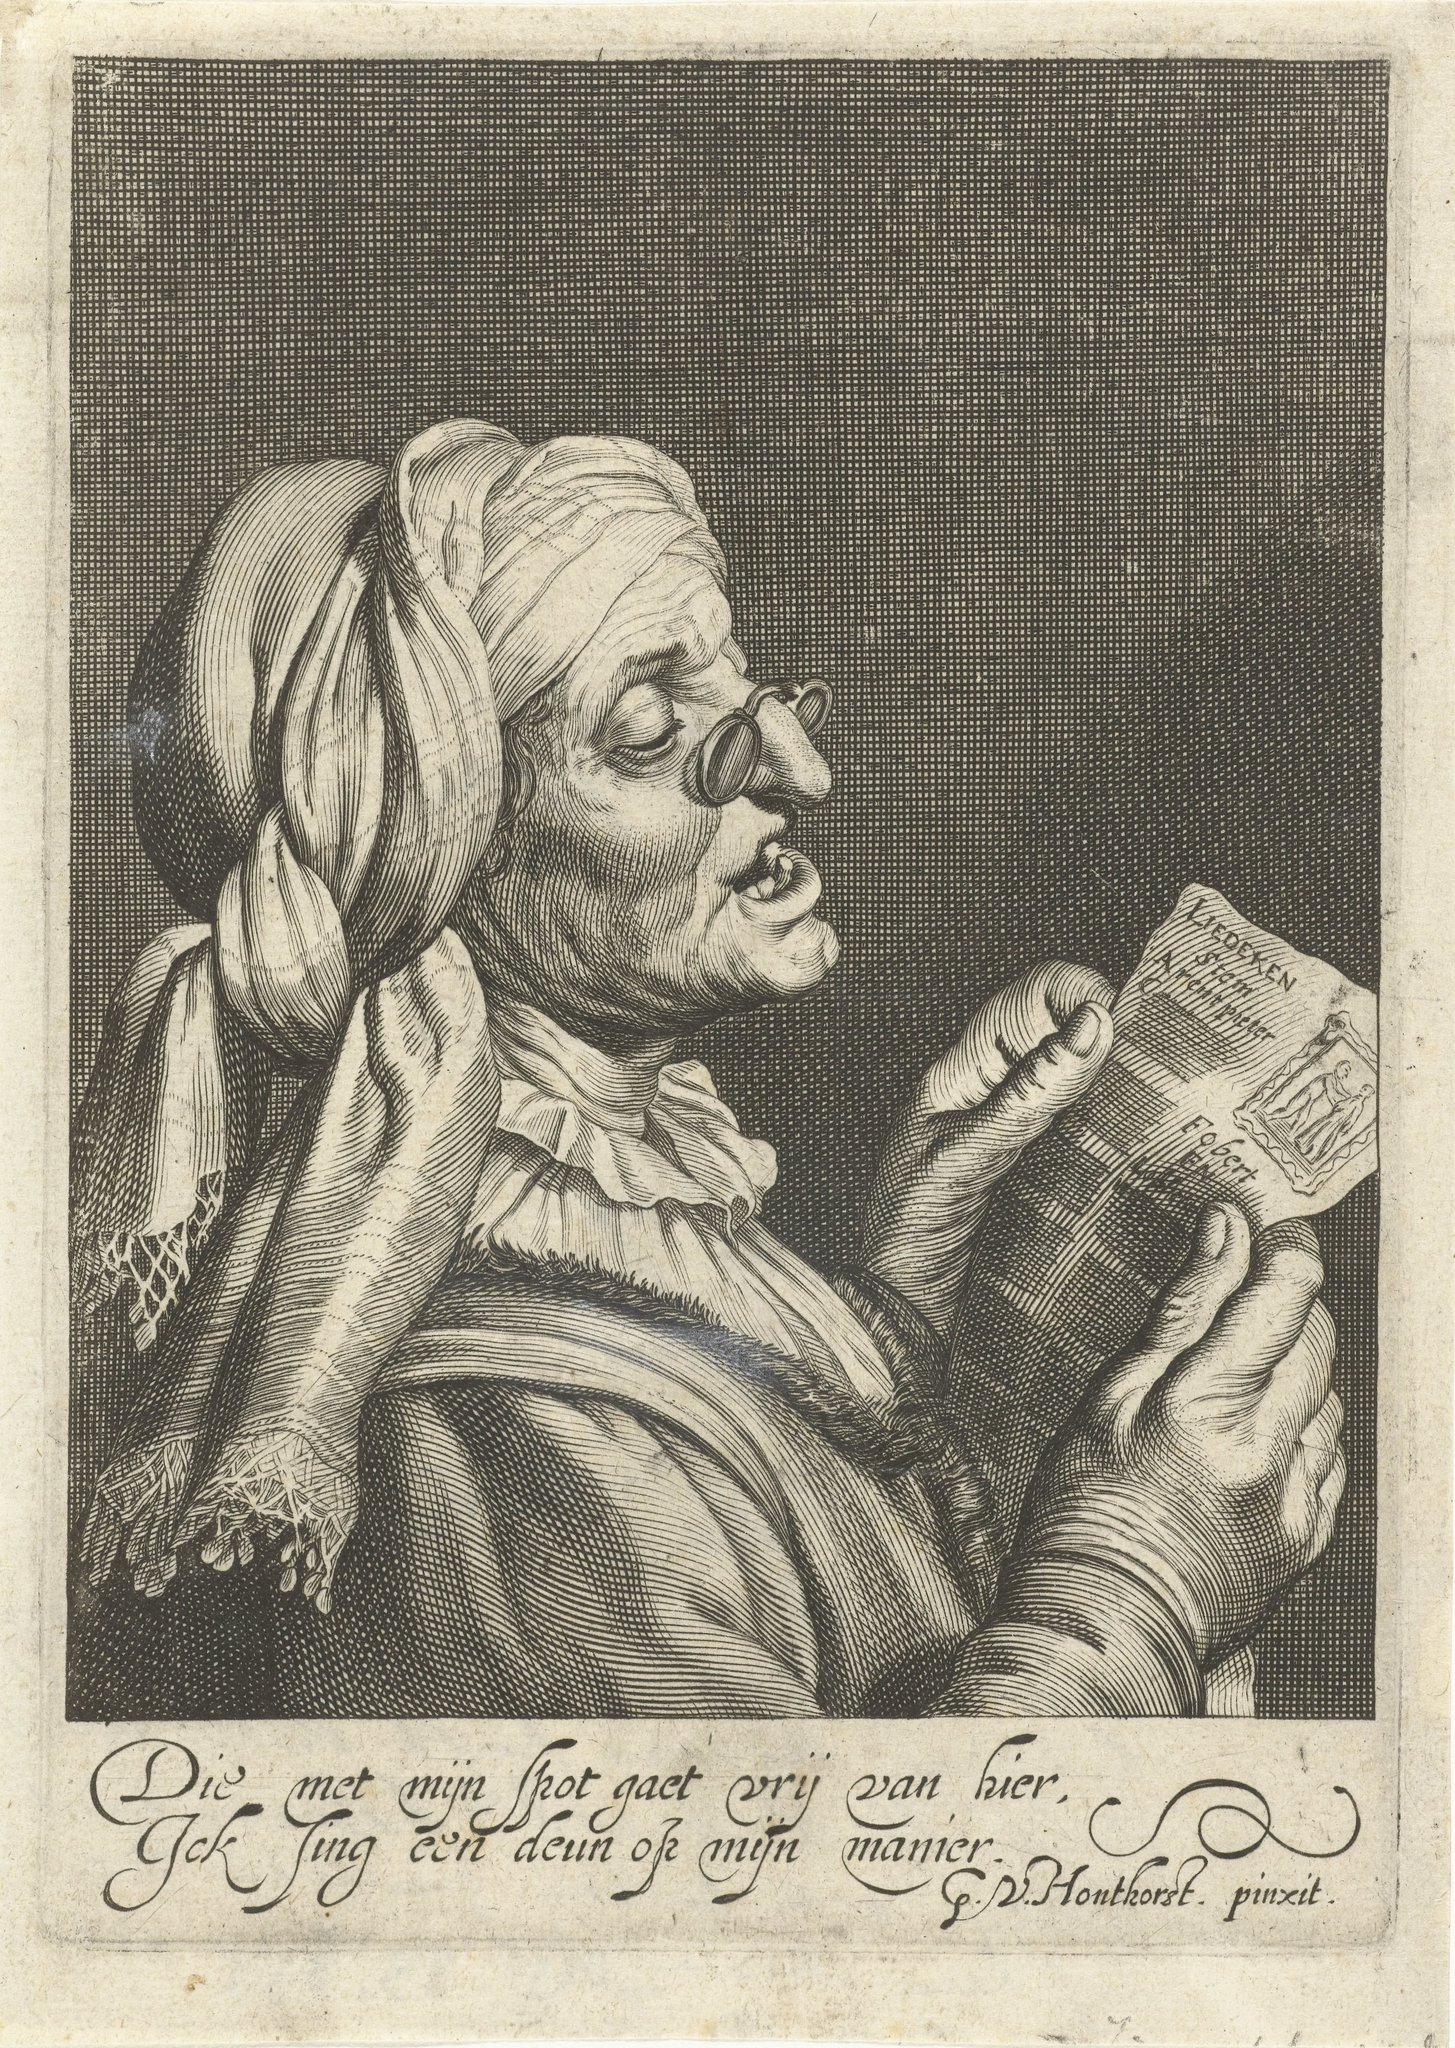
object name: print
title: Oude vrouw zingt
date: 1612-1665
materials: paper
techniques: engraving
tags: old woman, vocal music, singing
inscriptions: collector's mark: Lugt 2228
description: Oude vrouw met bril op haar kromme neus zingt een lied dat zij leest van een blad papier voor zich. In de ondermarge een Nederlands vers in twee regels dat de luisteraar waarschuwt om zich van commentaar te houden.